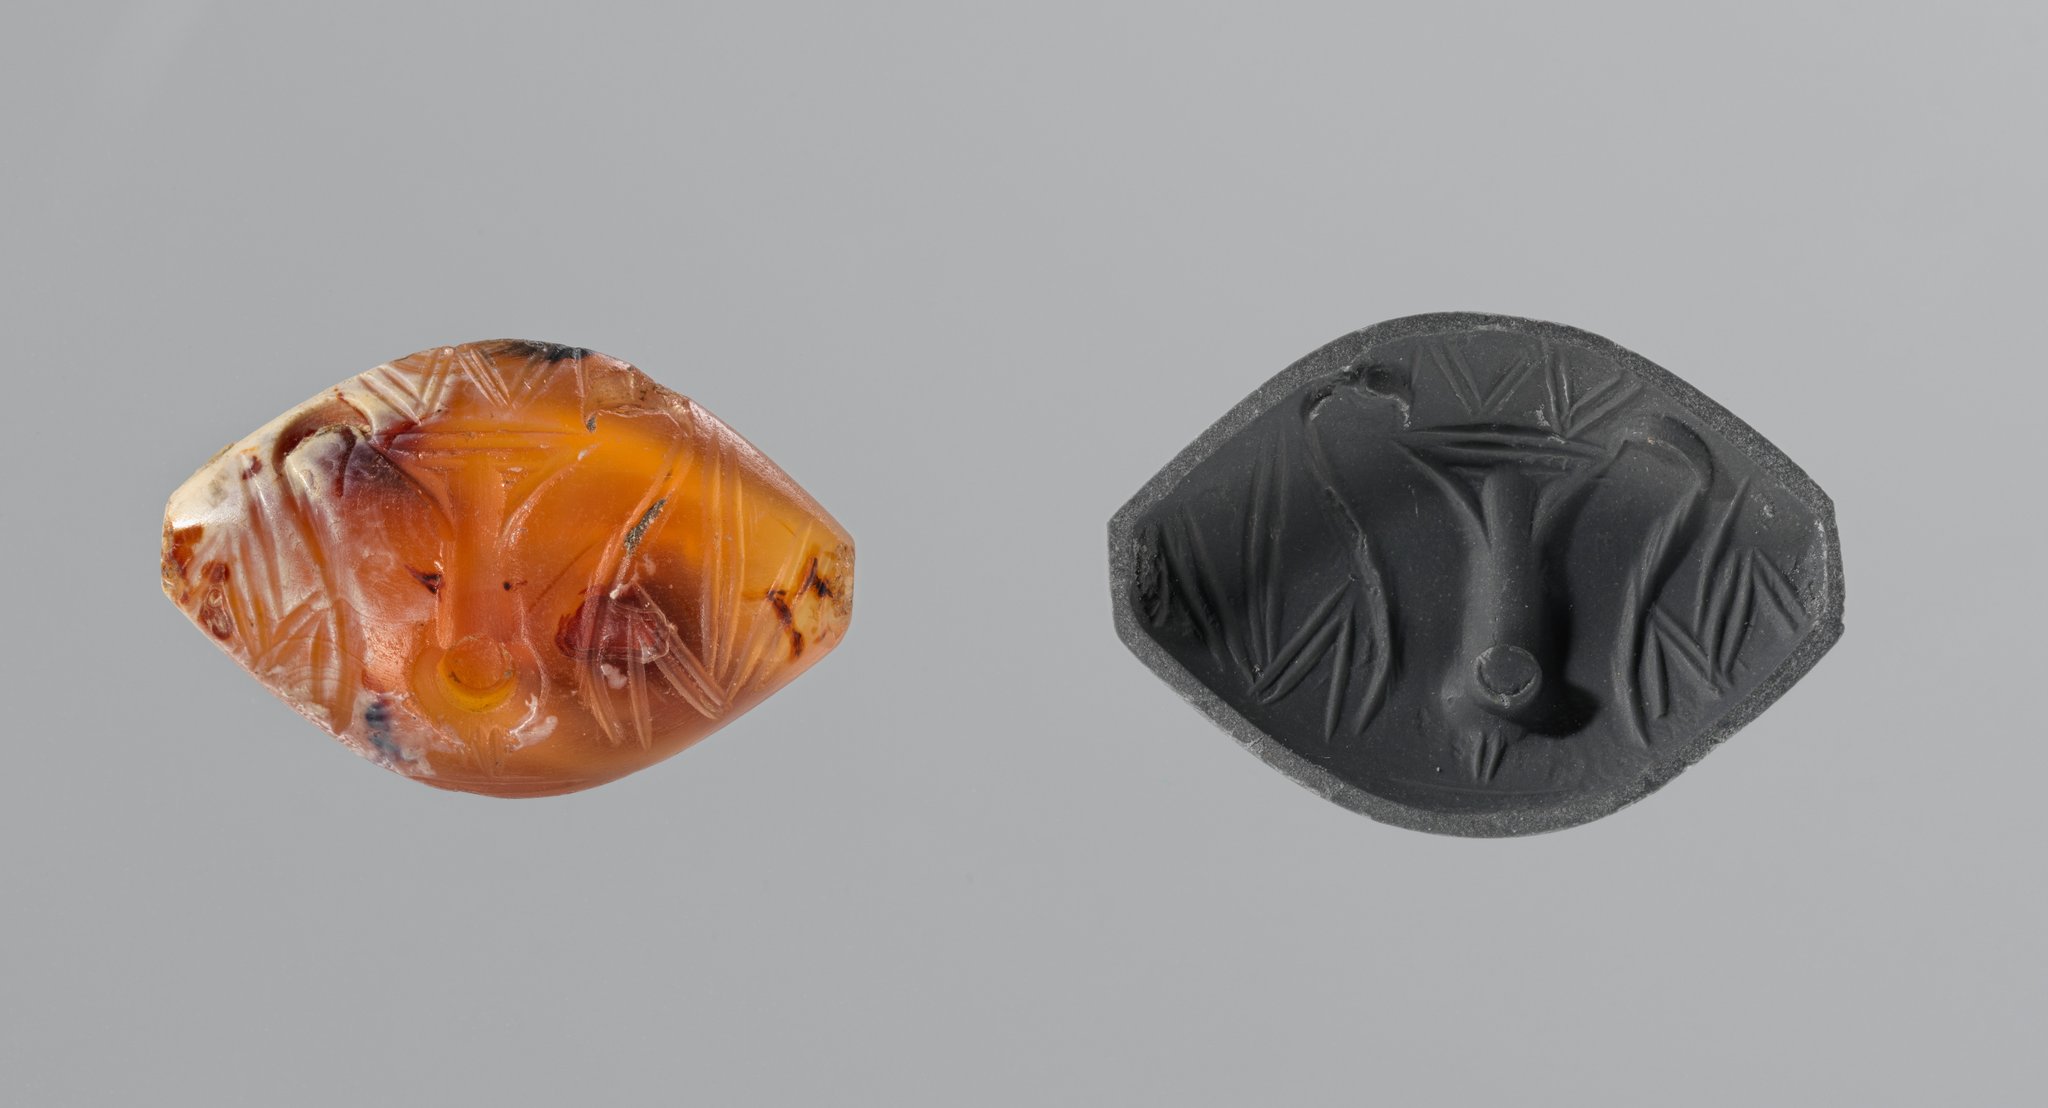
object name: seal, amygdaloid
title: Sard Amygdaloid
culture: minoan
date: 1650-1500 BCE